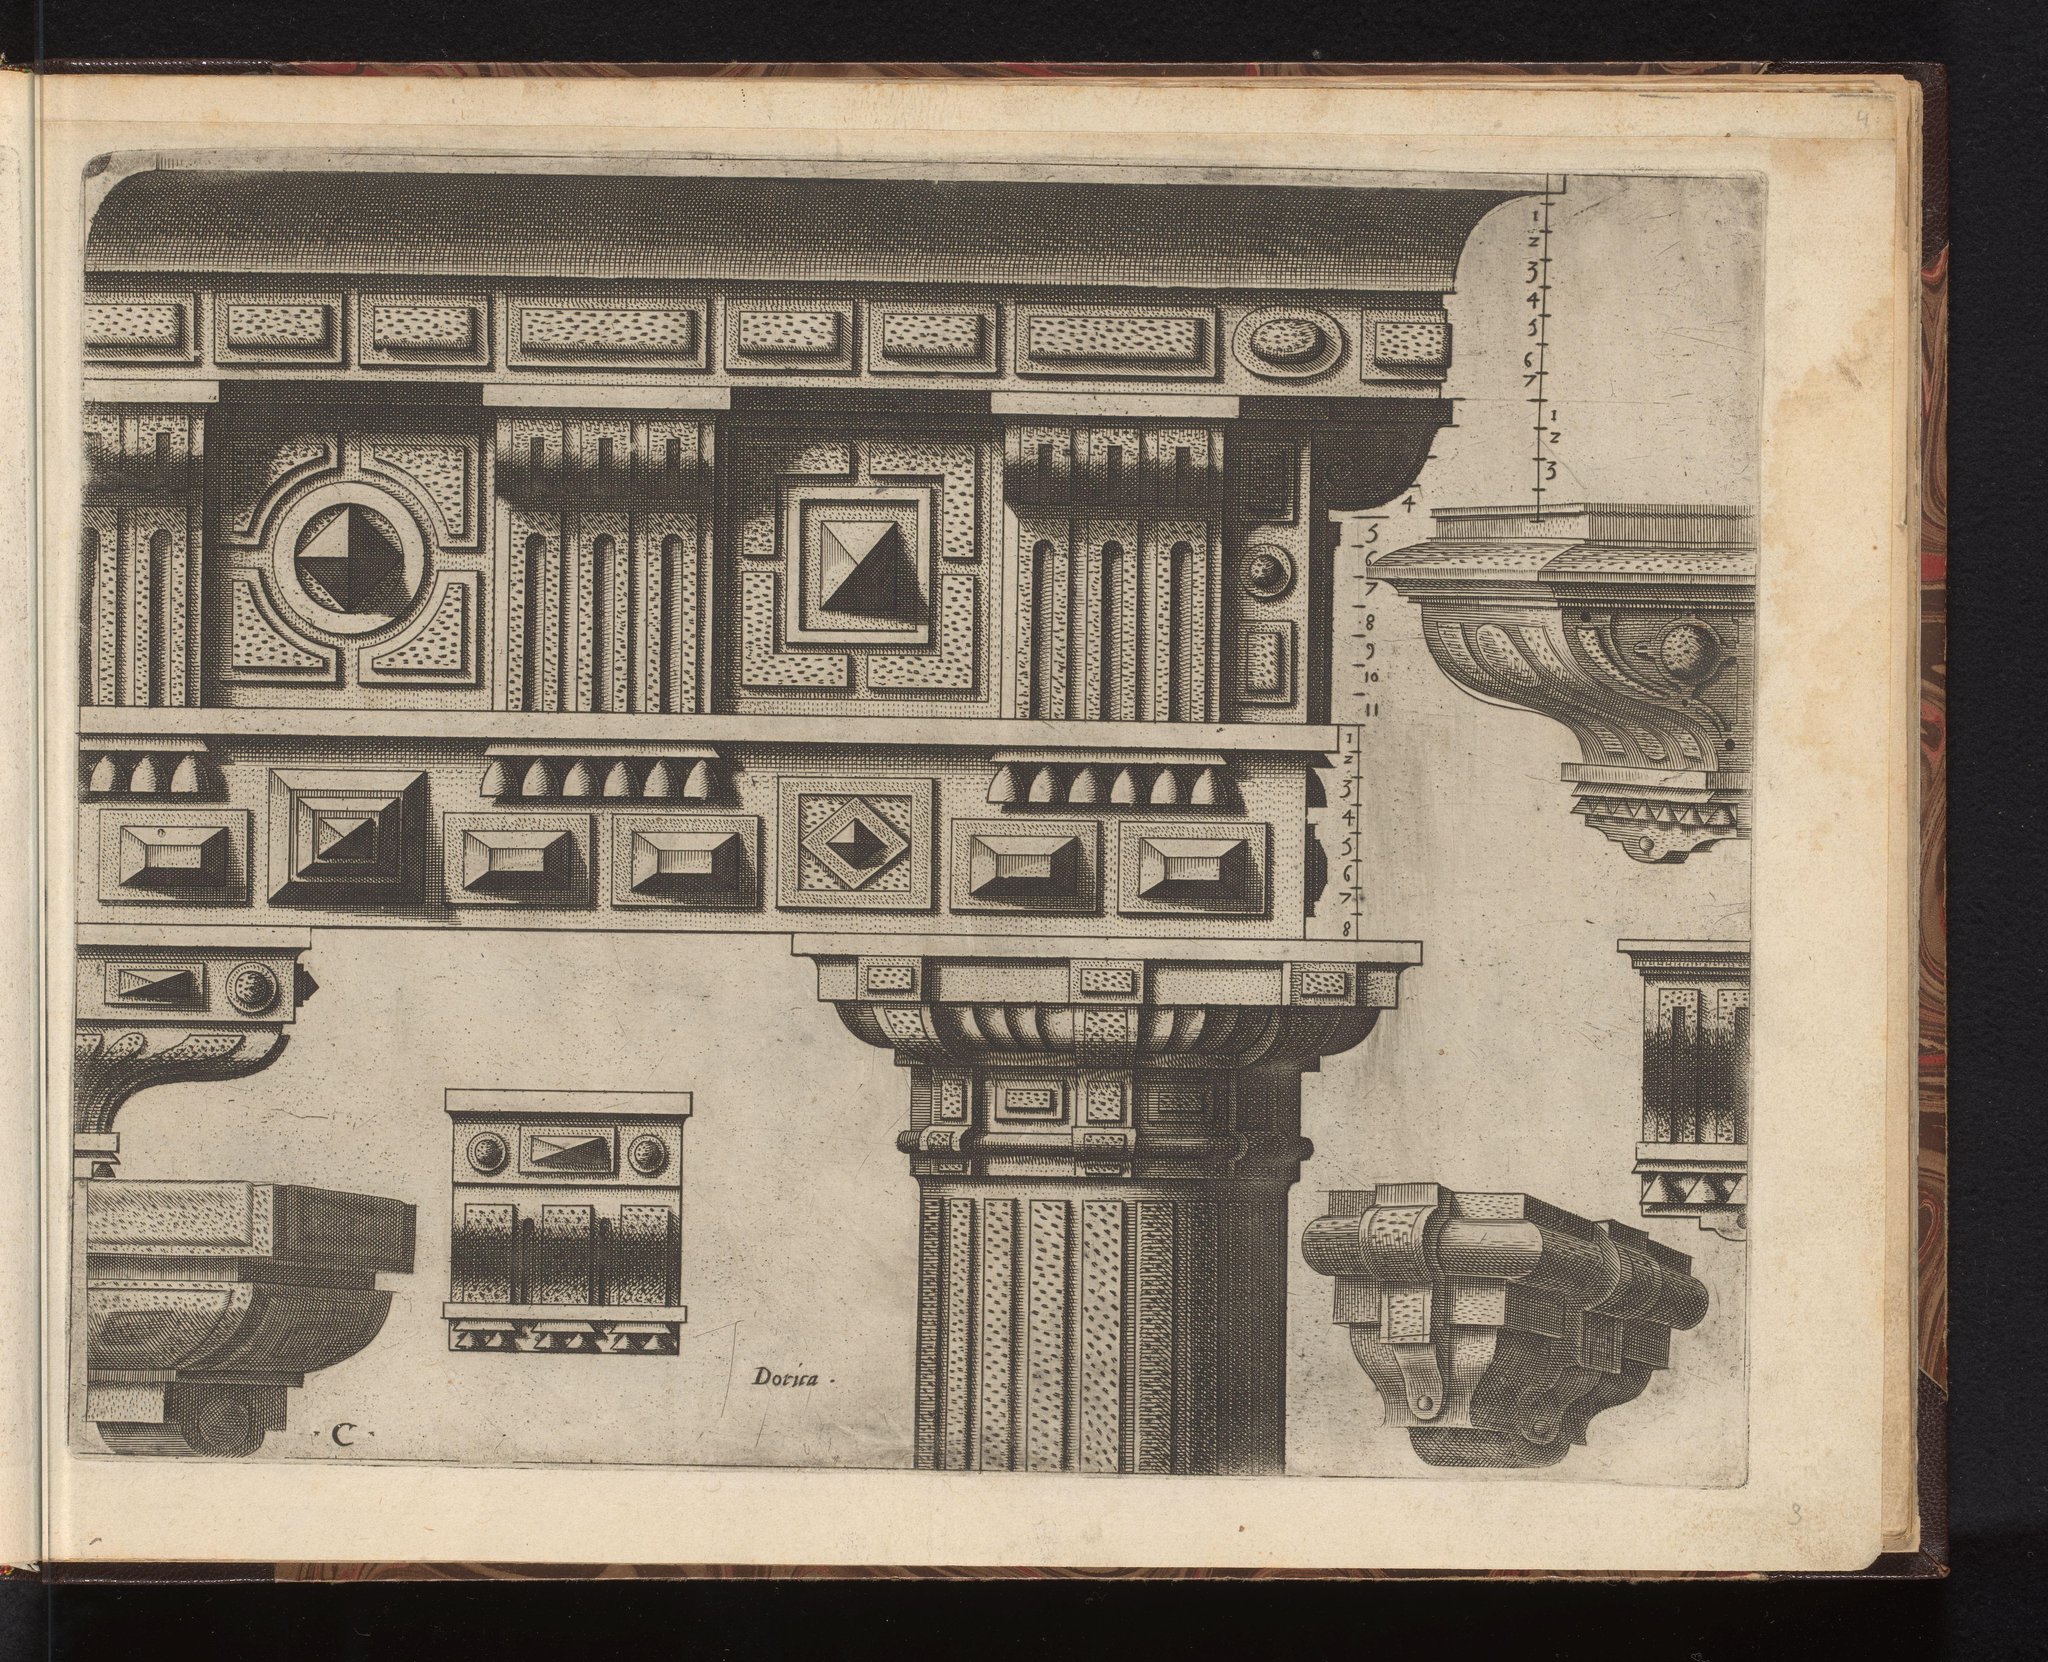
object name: print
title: Den eersten boeck ghemaeckt op de twee Colomnen Dorica en Ionica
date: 1565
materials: paper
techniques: etching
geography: antwerp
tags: doric order ~ architecture, other architectural details (console), other architectural details (entablature)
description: Dorisch hoofdgestel, gedecoreerd met bossage. Daarbij meerdere ontwerpen voor consoles. Op de voorstelling is drie keer een schaalverdeling aangegeven. Blad C. De prent maakt deel uit van een album.